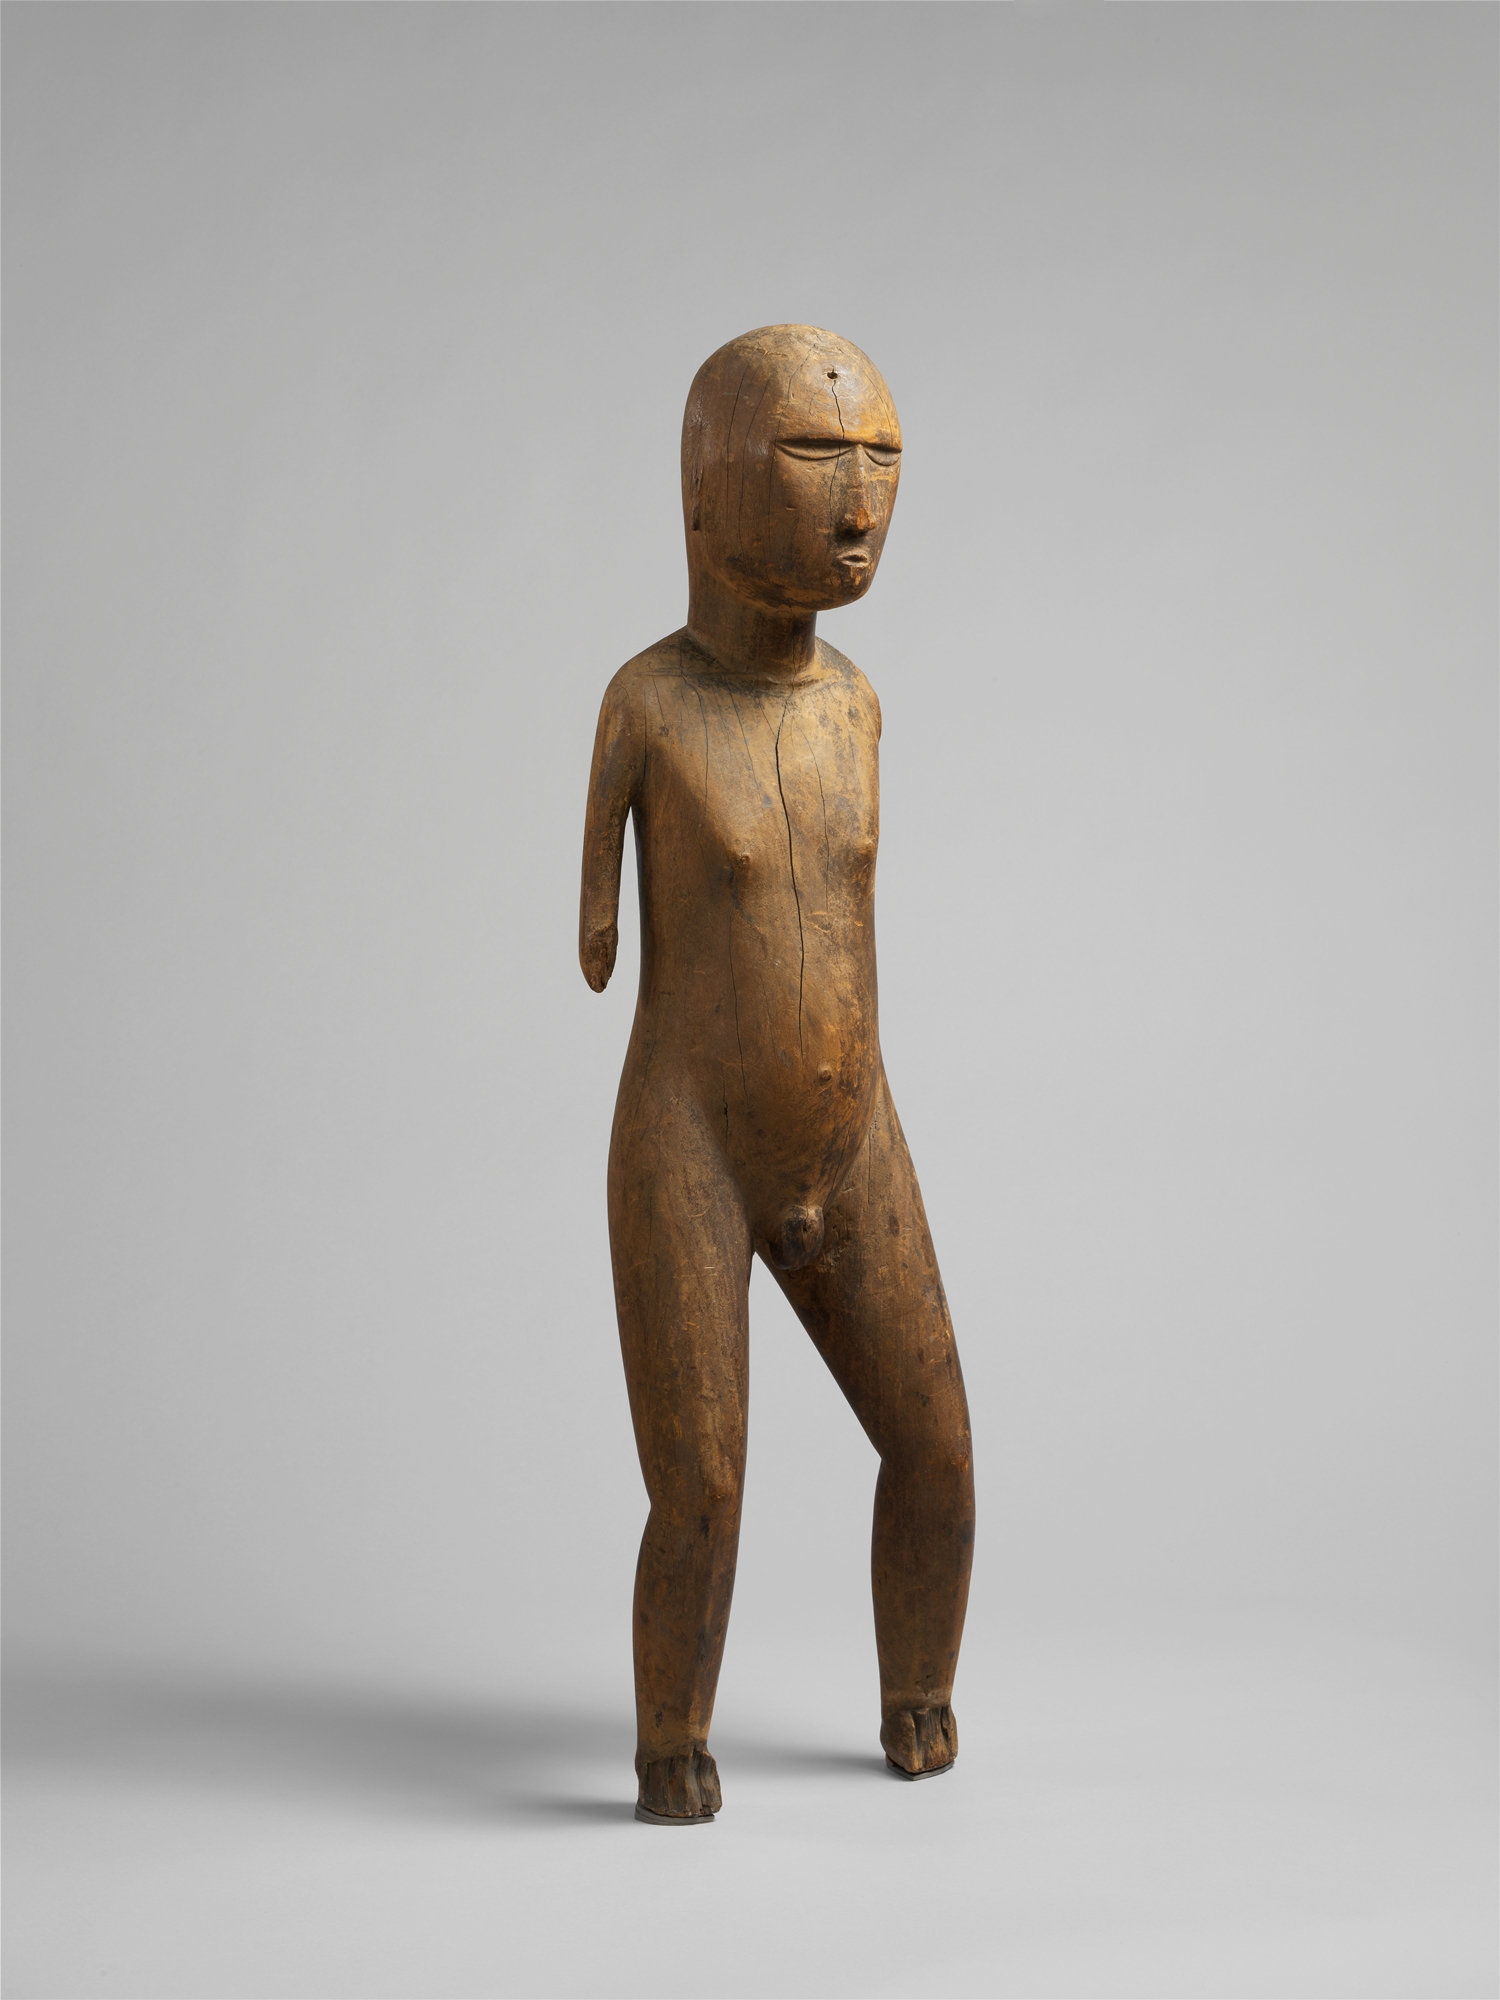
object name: figure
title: Male figure (tiki) representing the deity Rongo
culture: mangarevan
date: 1801-1833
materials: wood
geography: mangareva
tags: male nudes,deities